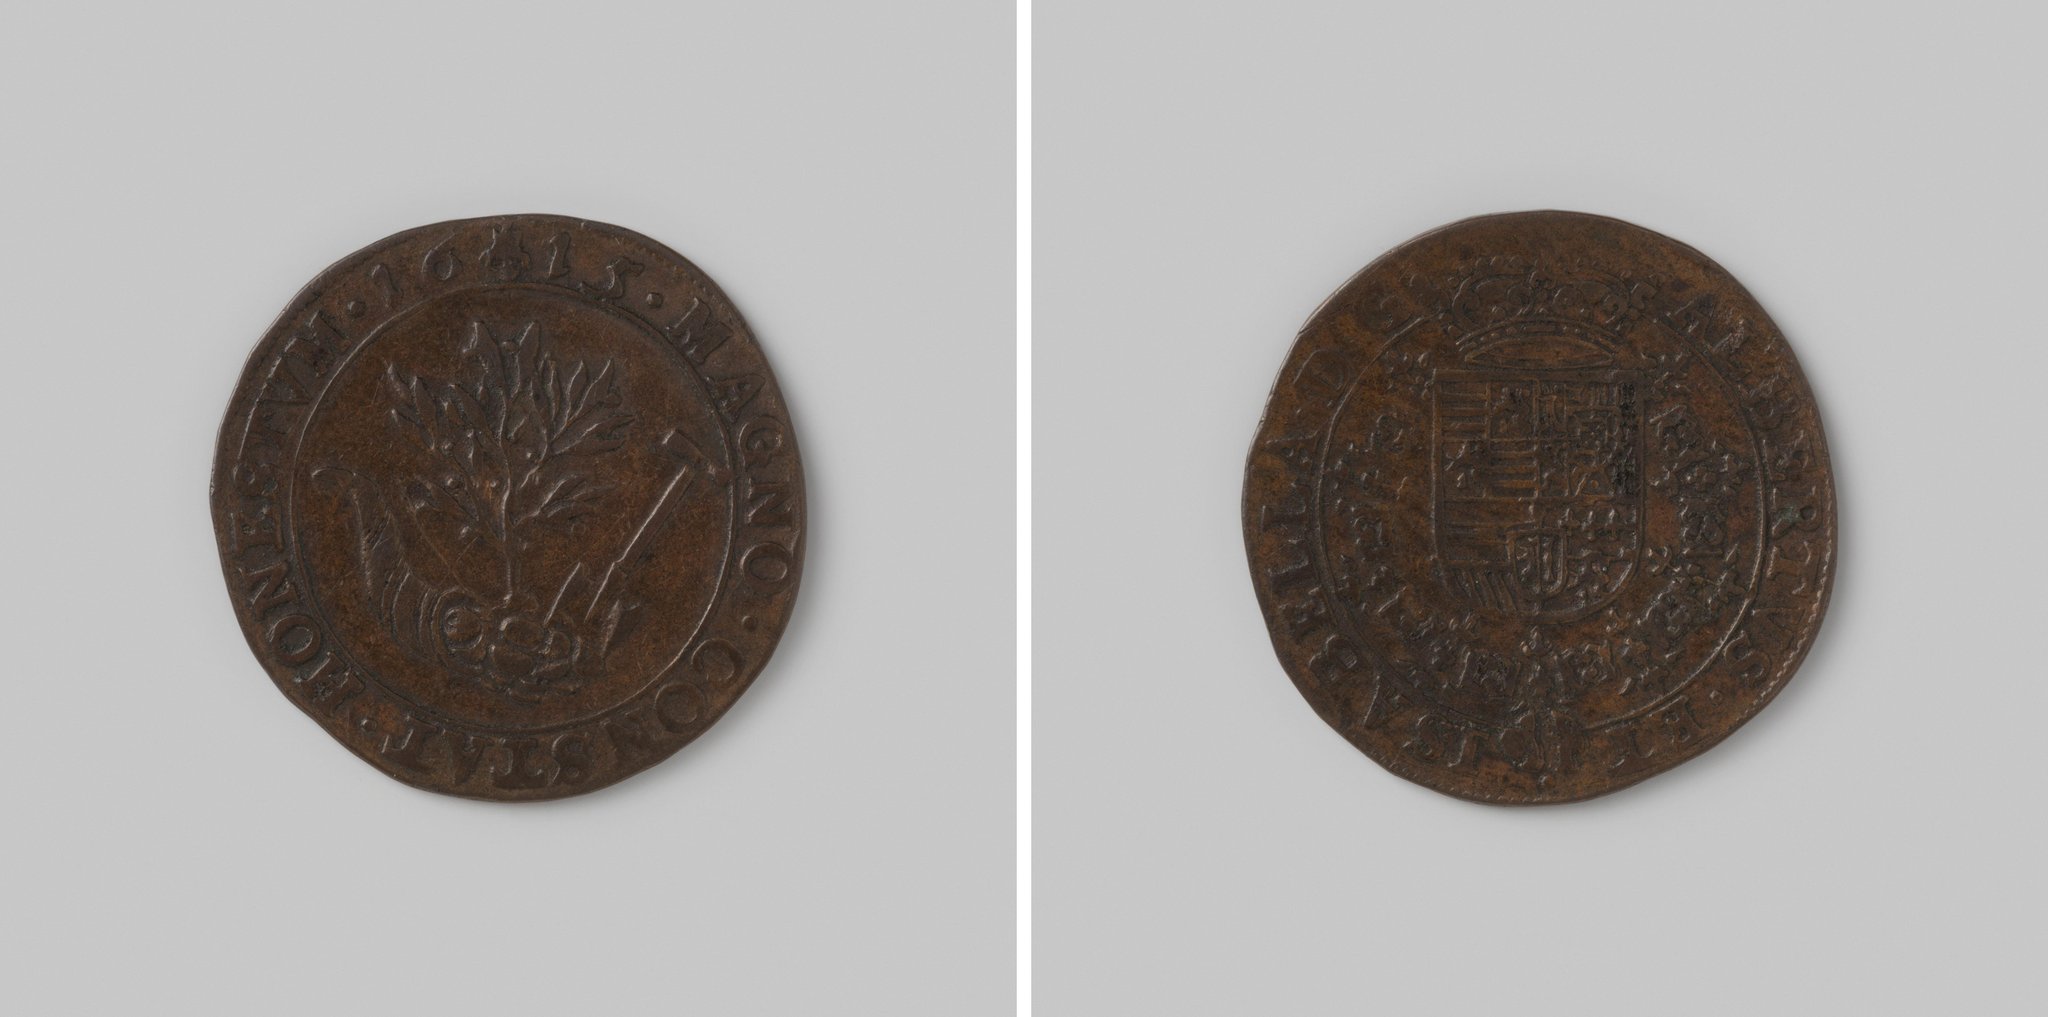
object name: history medal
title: Rekenpenning uit Brussel o de voorspoed van de Nederlanden 1615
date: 1615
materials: copper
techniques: striking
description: Koperen penning, op de voorzijde een hoorn des overvloeds, een vruchtdragende boom en een spade, met omschrift, op de keerzijde het gekroonde Spaanse wapenschild omhangen met de keten van het Gulden Vlies, met omschrift.